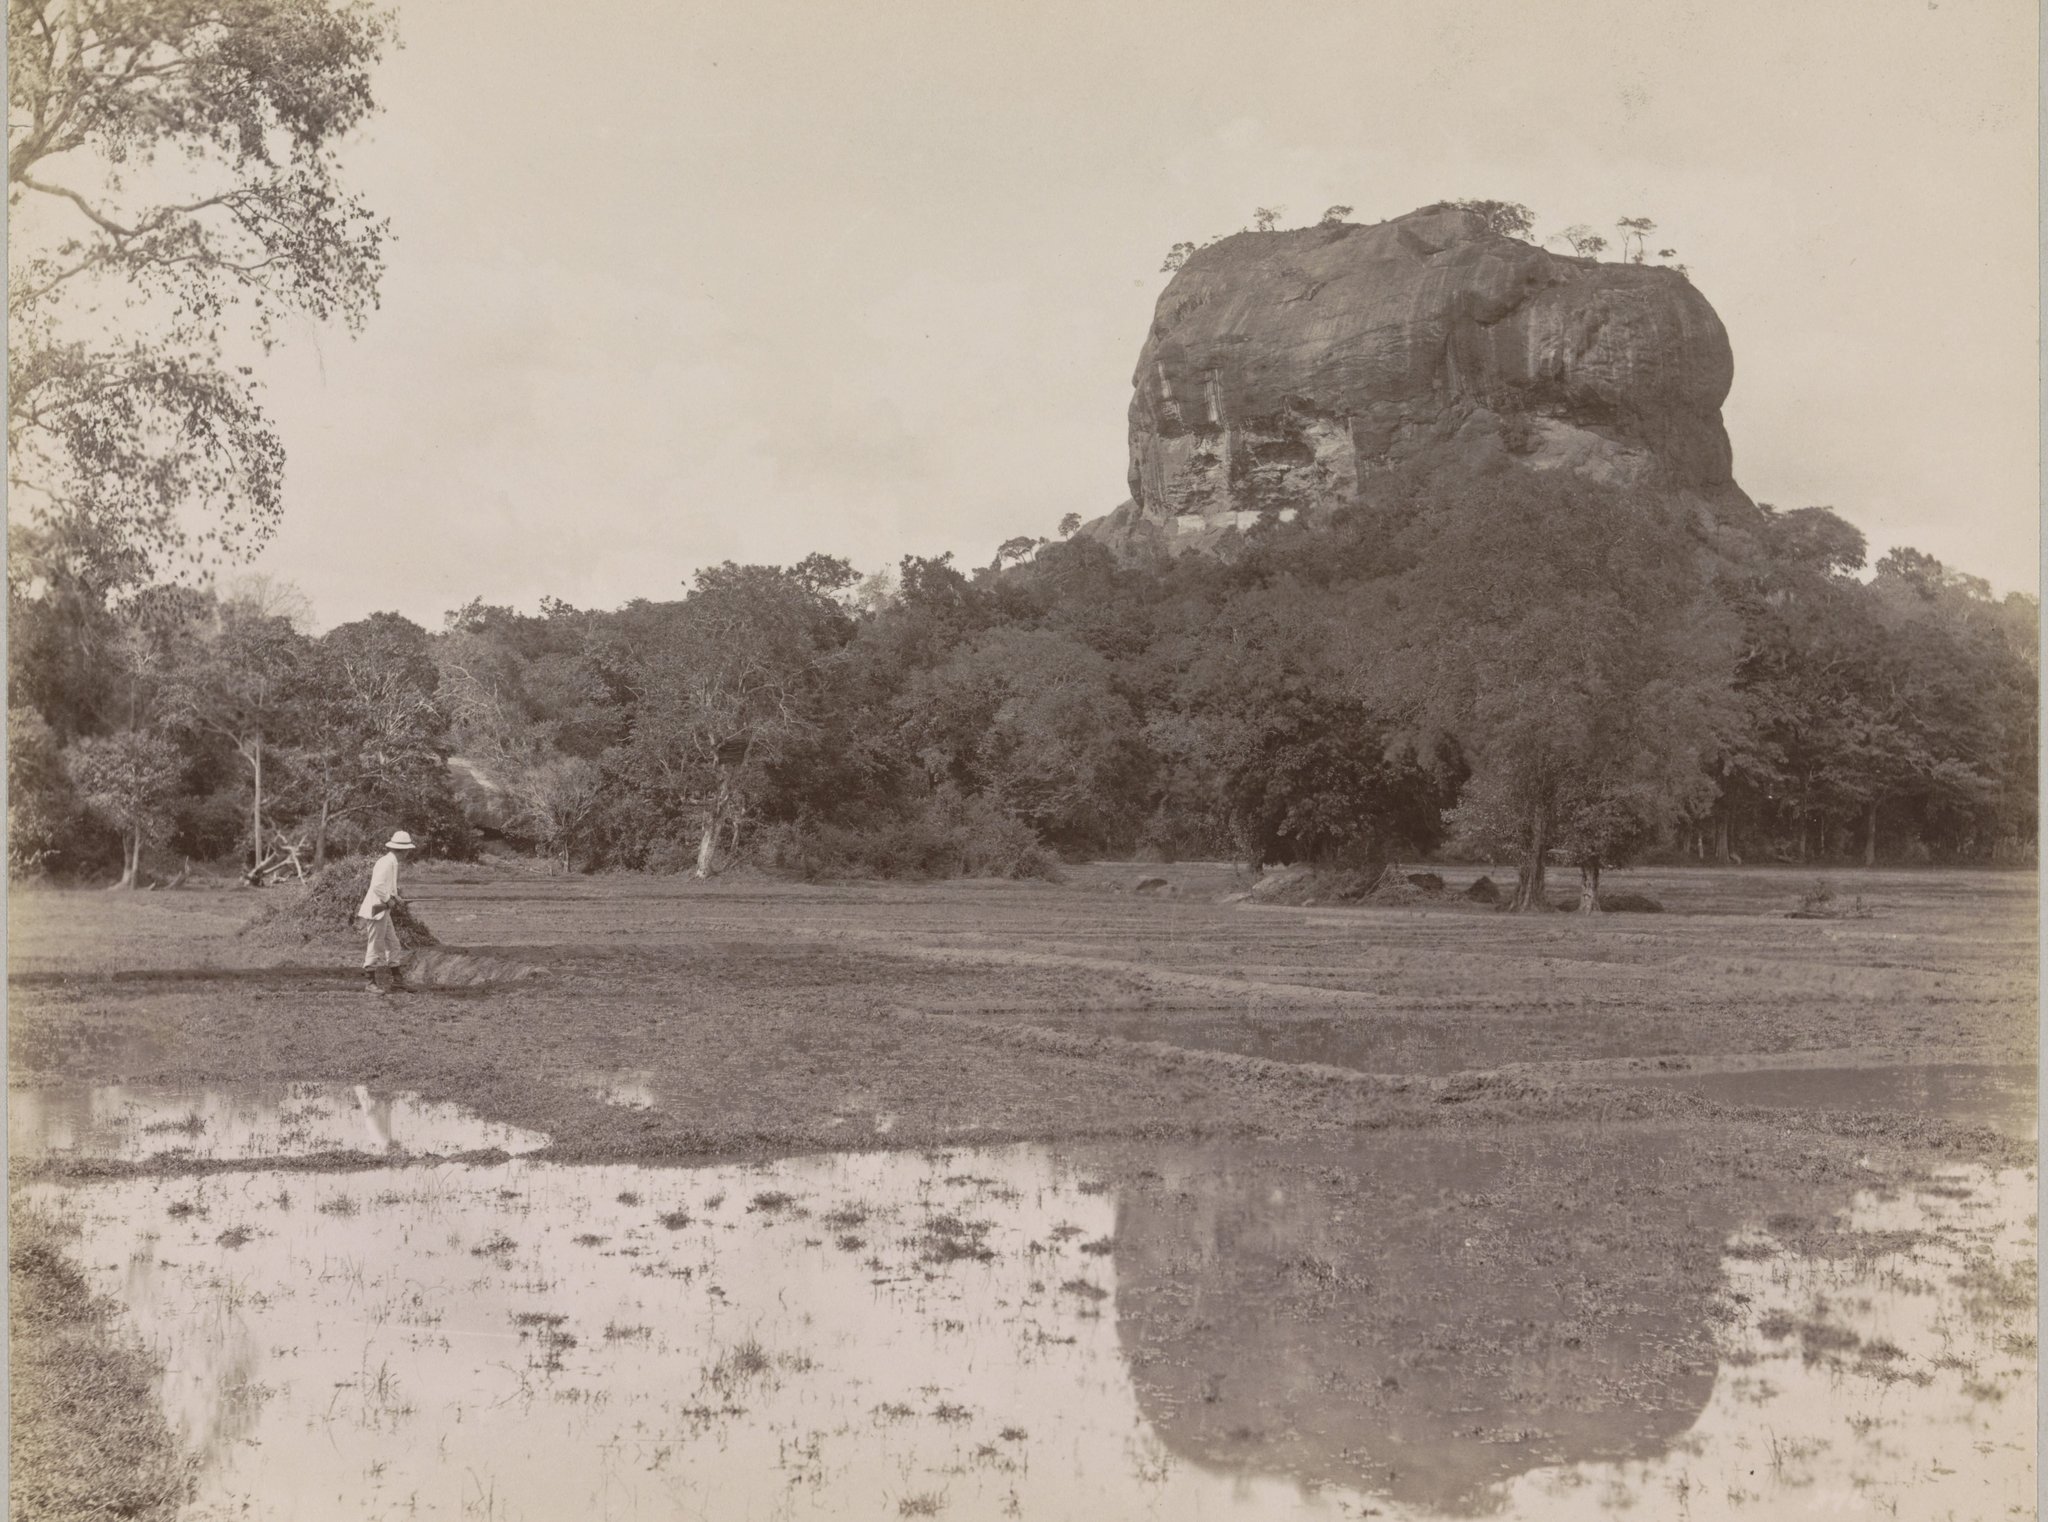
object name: photograph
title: View of the rock fortress of Sigiriya, Sri Lanka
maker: Anonymous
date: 1895-1915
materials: cardboard, paper, photographic support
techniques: albumen print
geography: sigiriya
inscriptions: inscription: ‘6. Sigiri’